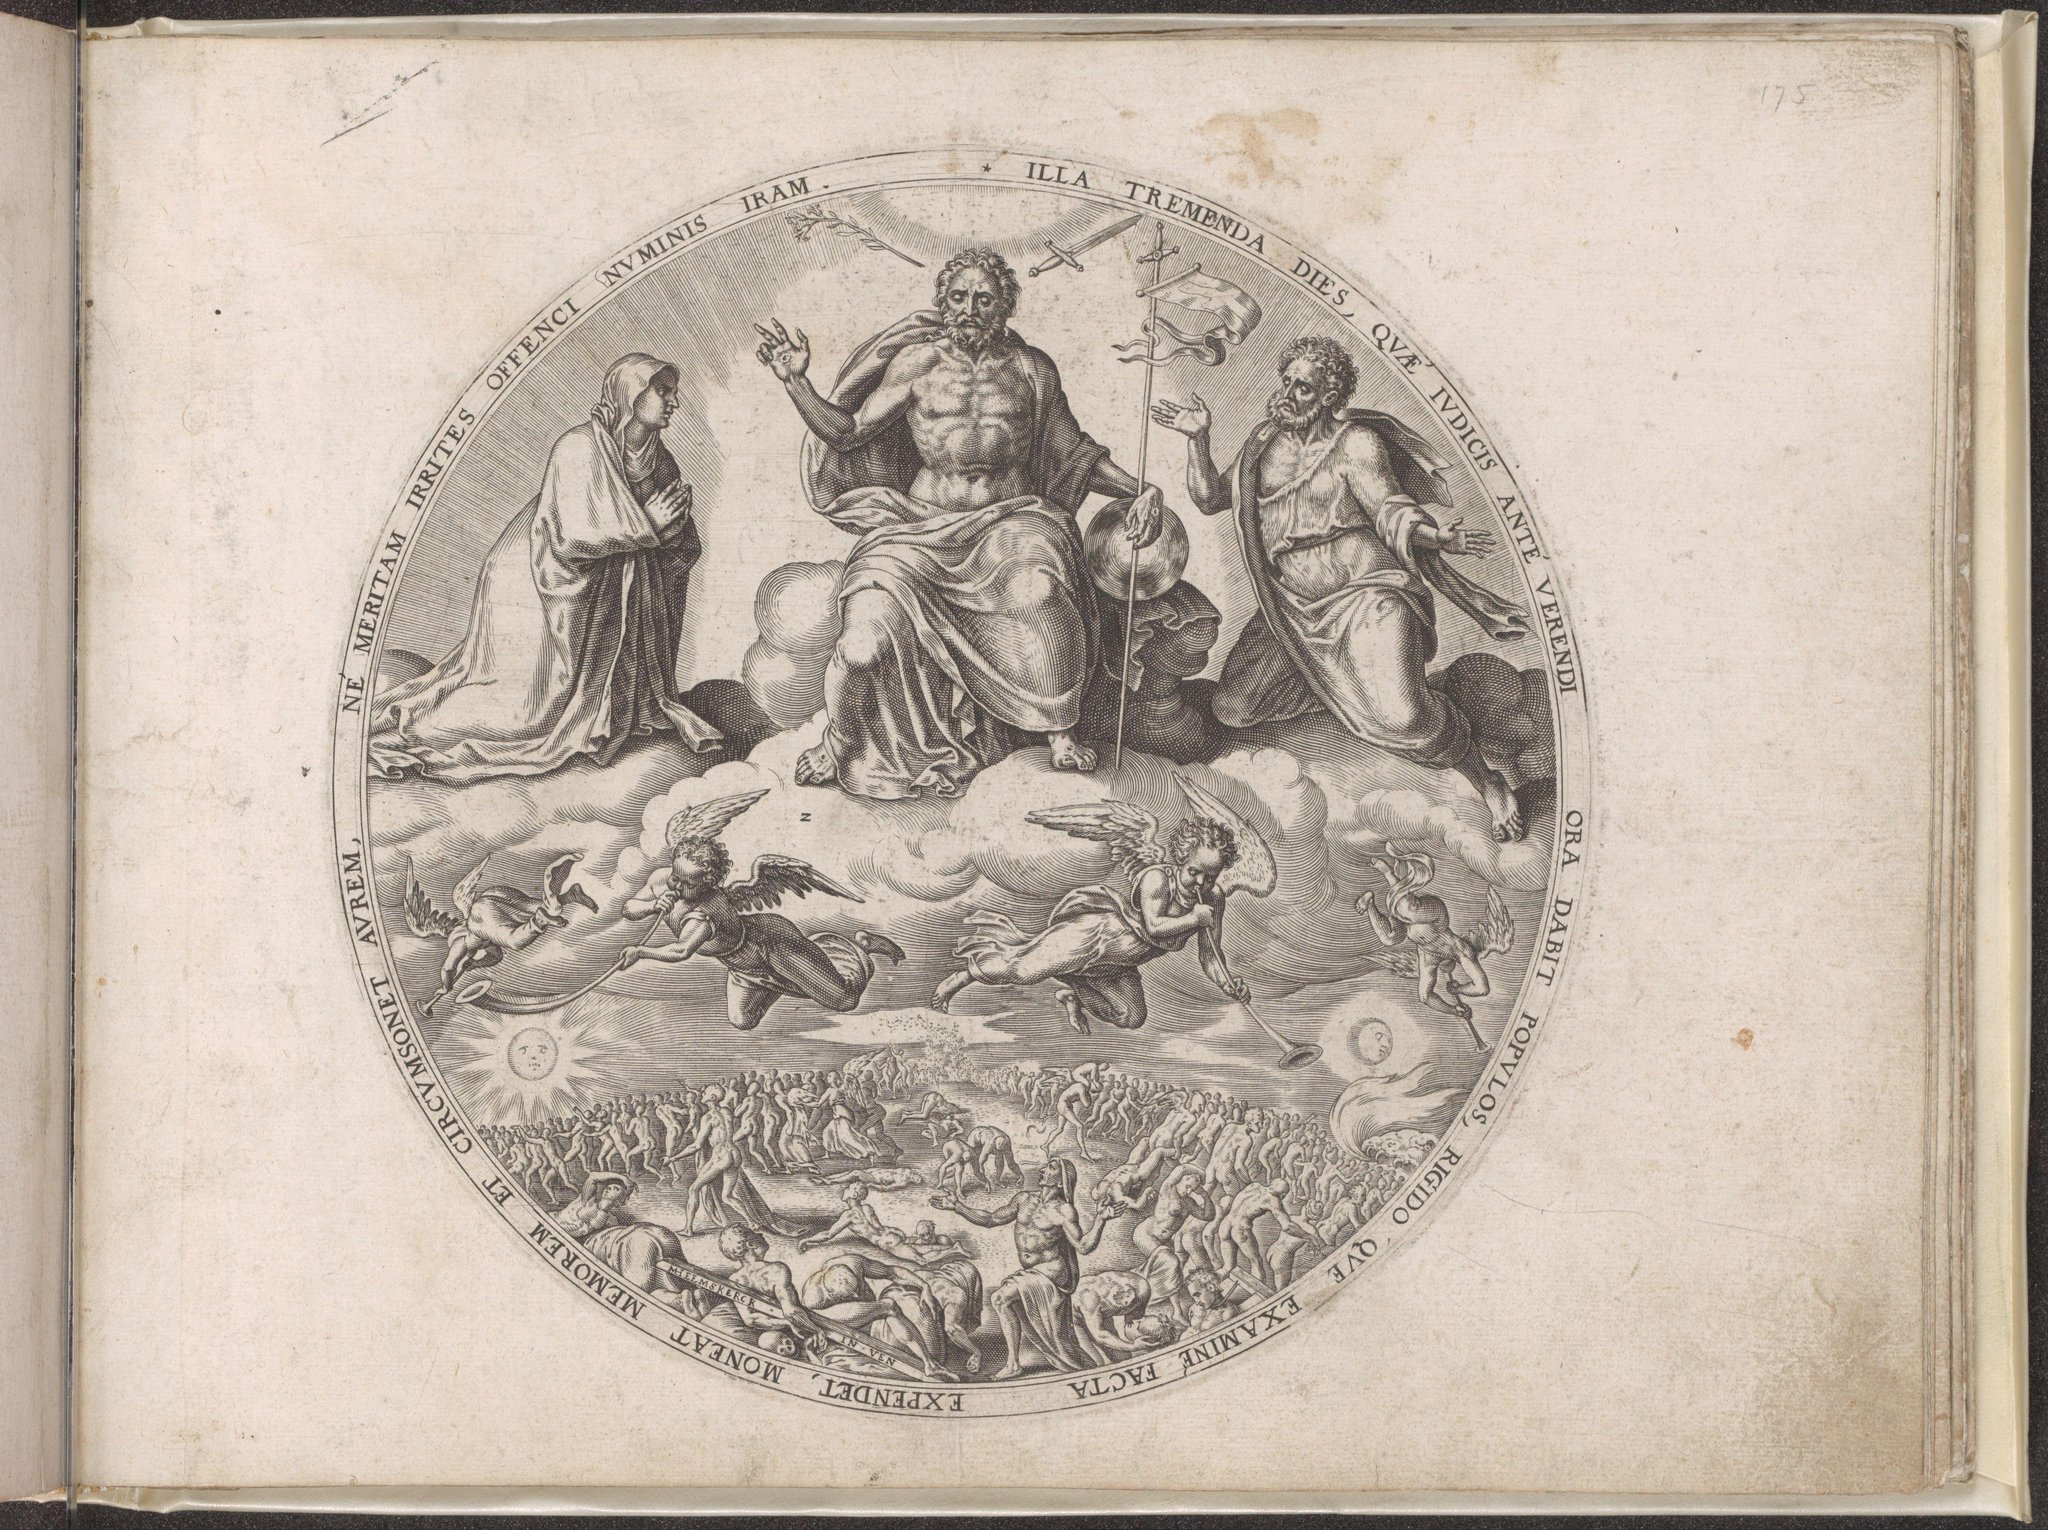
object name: album leaf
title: Vier laatste dingen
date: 1569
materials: paper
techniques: engraving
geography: haarlem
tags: comprehensive representation of last judgement: christ (with sword and lily), often surrounded by elders and sometimes accompanied by mary and john the baptist, appears in the sky with trumpeting angels (and sometimes angels holding the instruments of the passion); after the resurrection of the dead the blessed are led to heaven by angels, and the damned are dragged into hell by devils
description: Christus troont op de wolken en velt het laatste oordeel. Naast hem knielen Maria en Johannes. Vier engelen blazen de bazuin, terwijl de doden opstaan. De zaligen lopen onder begeleiding van engelen naar links naar de hemel. De slechten worden door duivels rechts naar de hel gebracht. Rond de voorstelling een randtekst in het Latijn. Deze prent maakt deel uit van een album.